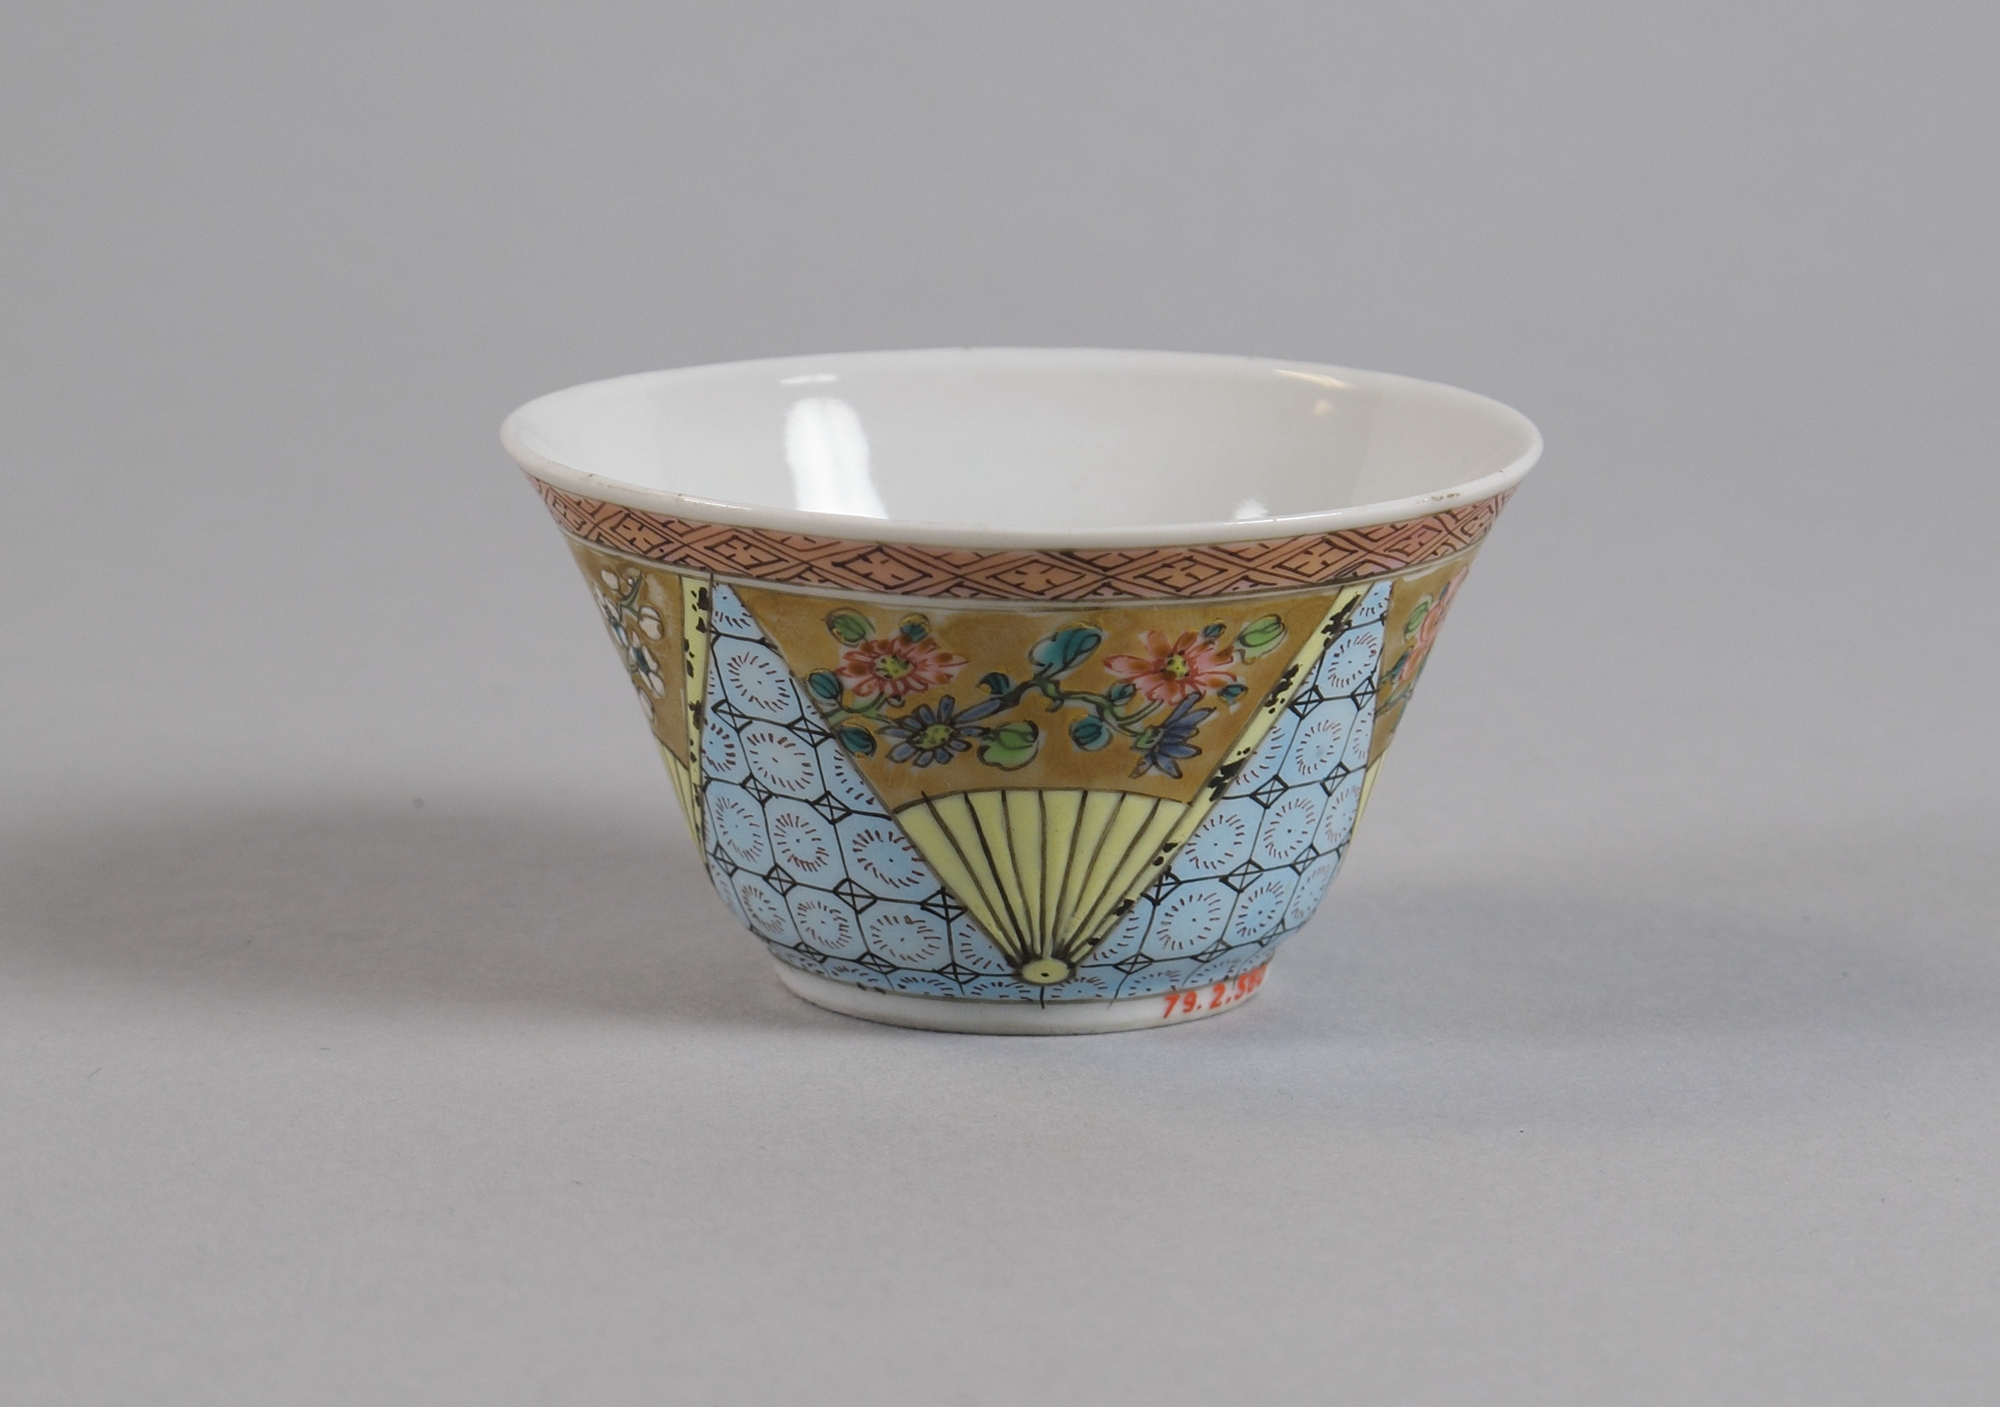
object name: cup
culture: chinese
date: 1644-1911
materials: enamel, porcelain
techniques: overglaze, painting, polychrome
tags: flowers